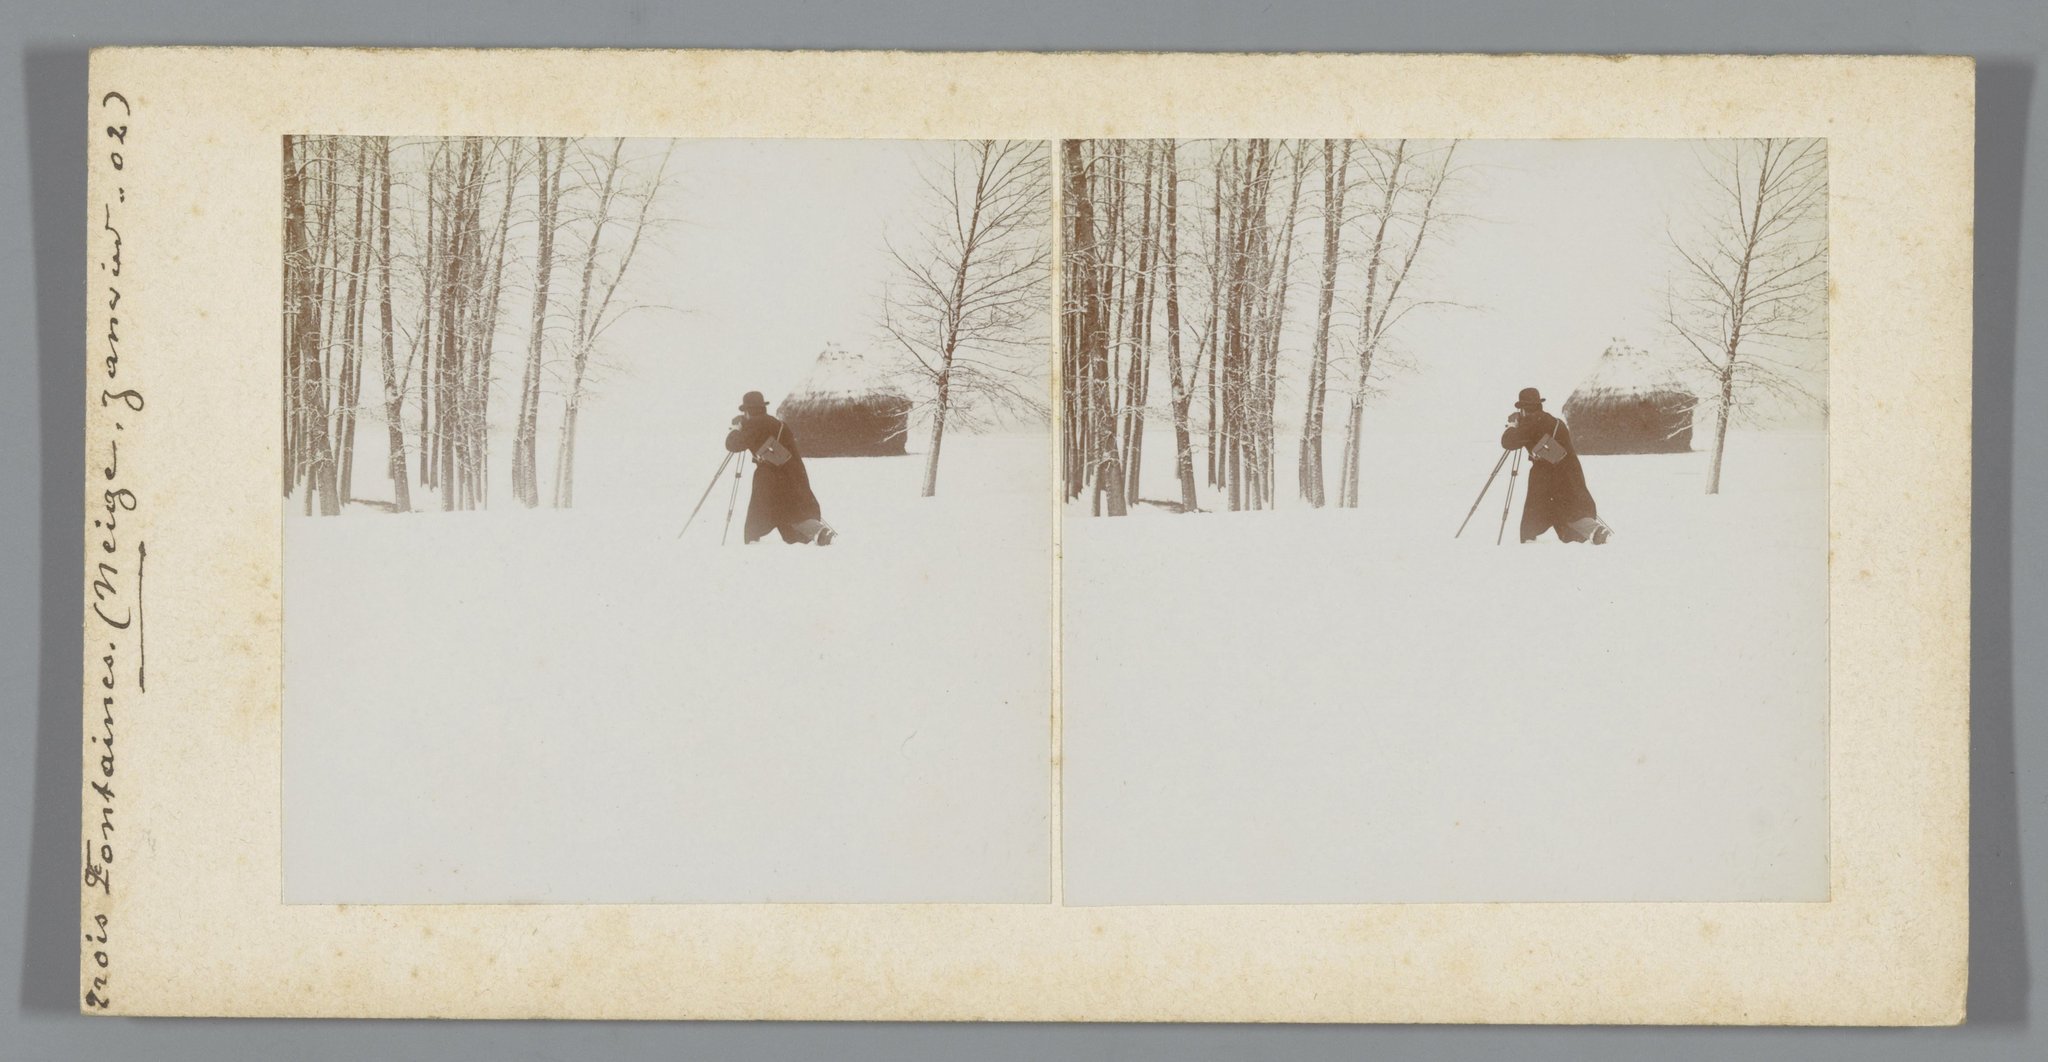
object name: stereograph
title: Fotograaf in een besneeuwd landschap nabij Trois-Fontaines-l'Abbaye, Frankrijk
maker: Anonymous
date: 1901-1902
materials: paper, cardboard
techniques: collodion silver print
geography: france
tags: photographer at work